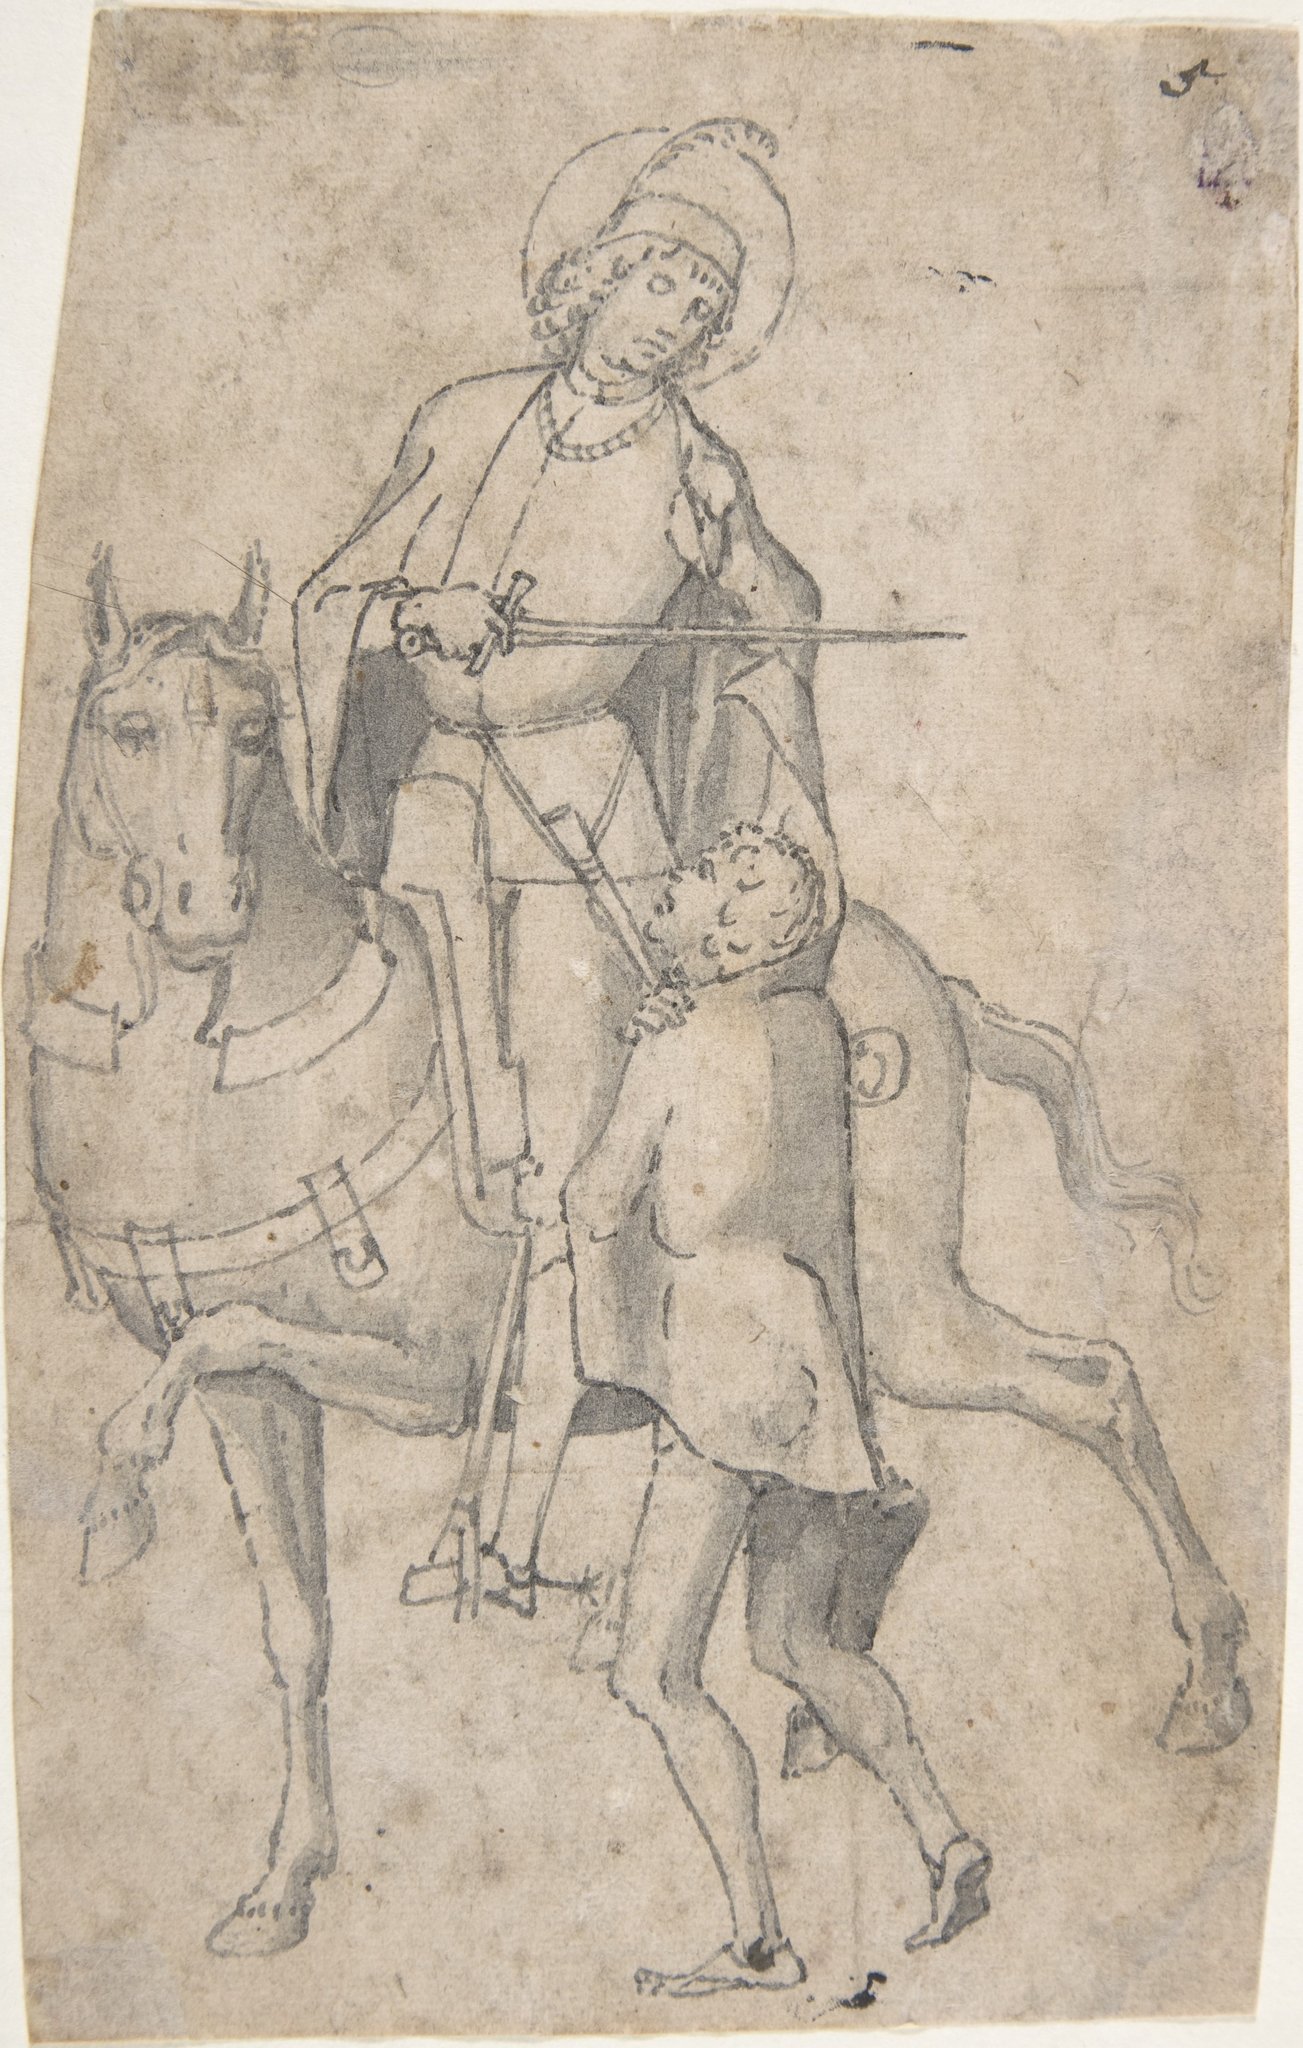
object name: drawing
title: Saint Martin and the Beggar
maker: vittore carpaccio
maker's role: artist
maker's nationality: italian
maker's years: 1460-1526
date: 1493-1500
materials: chalk, ink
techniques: brush, pen, wash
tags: swords,men,horses